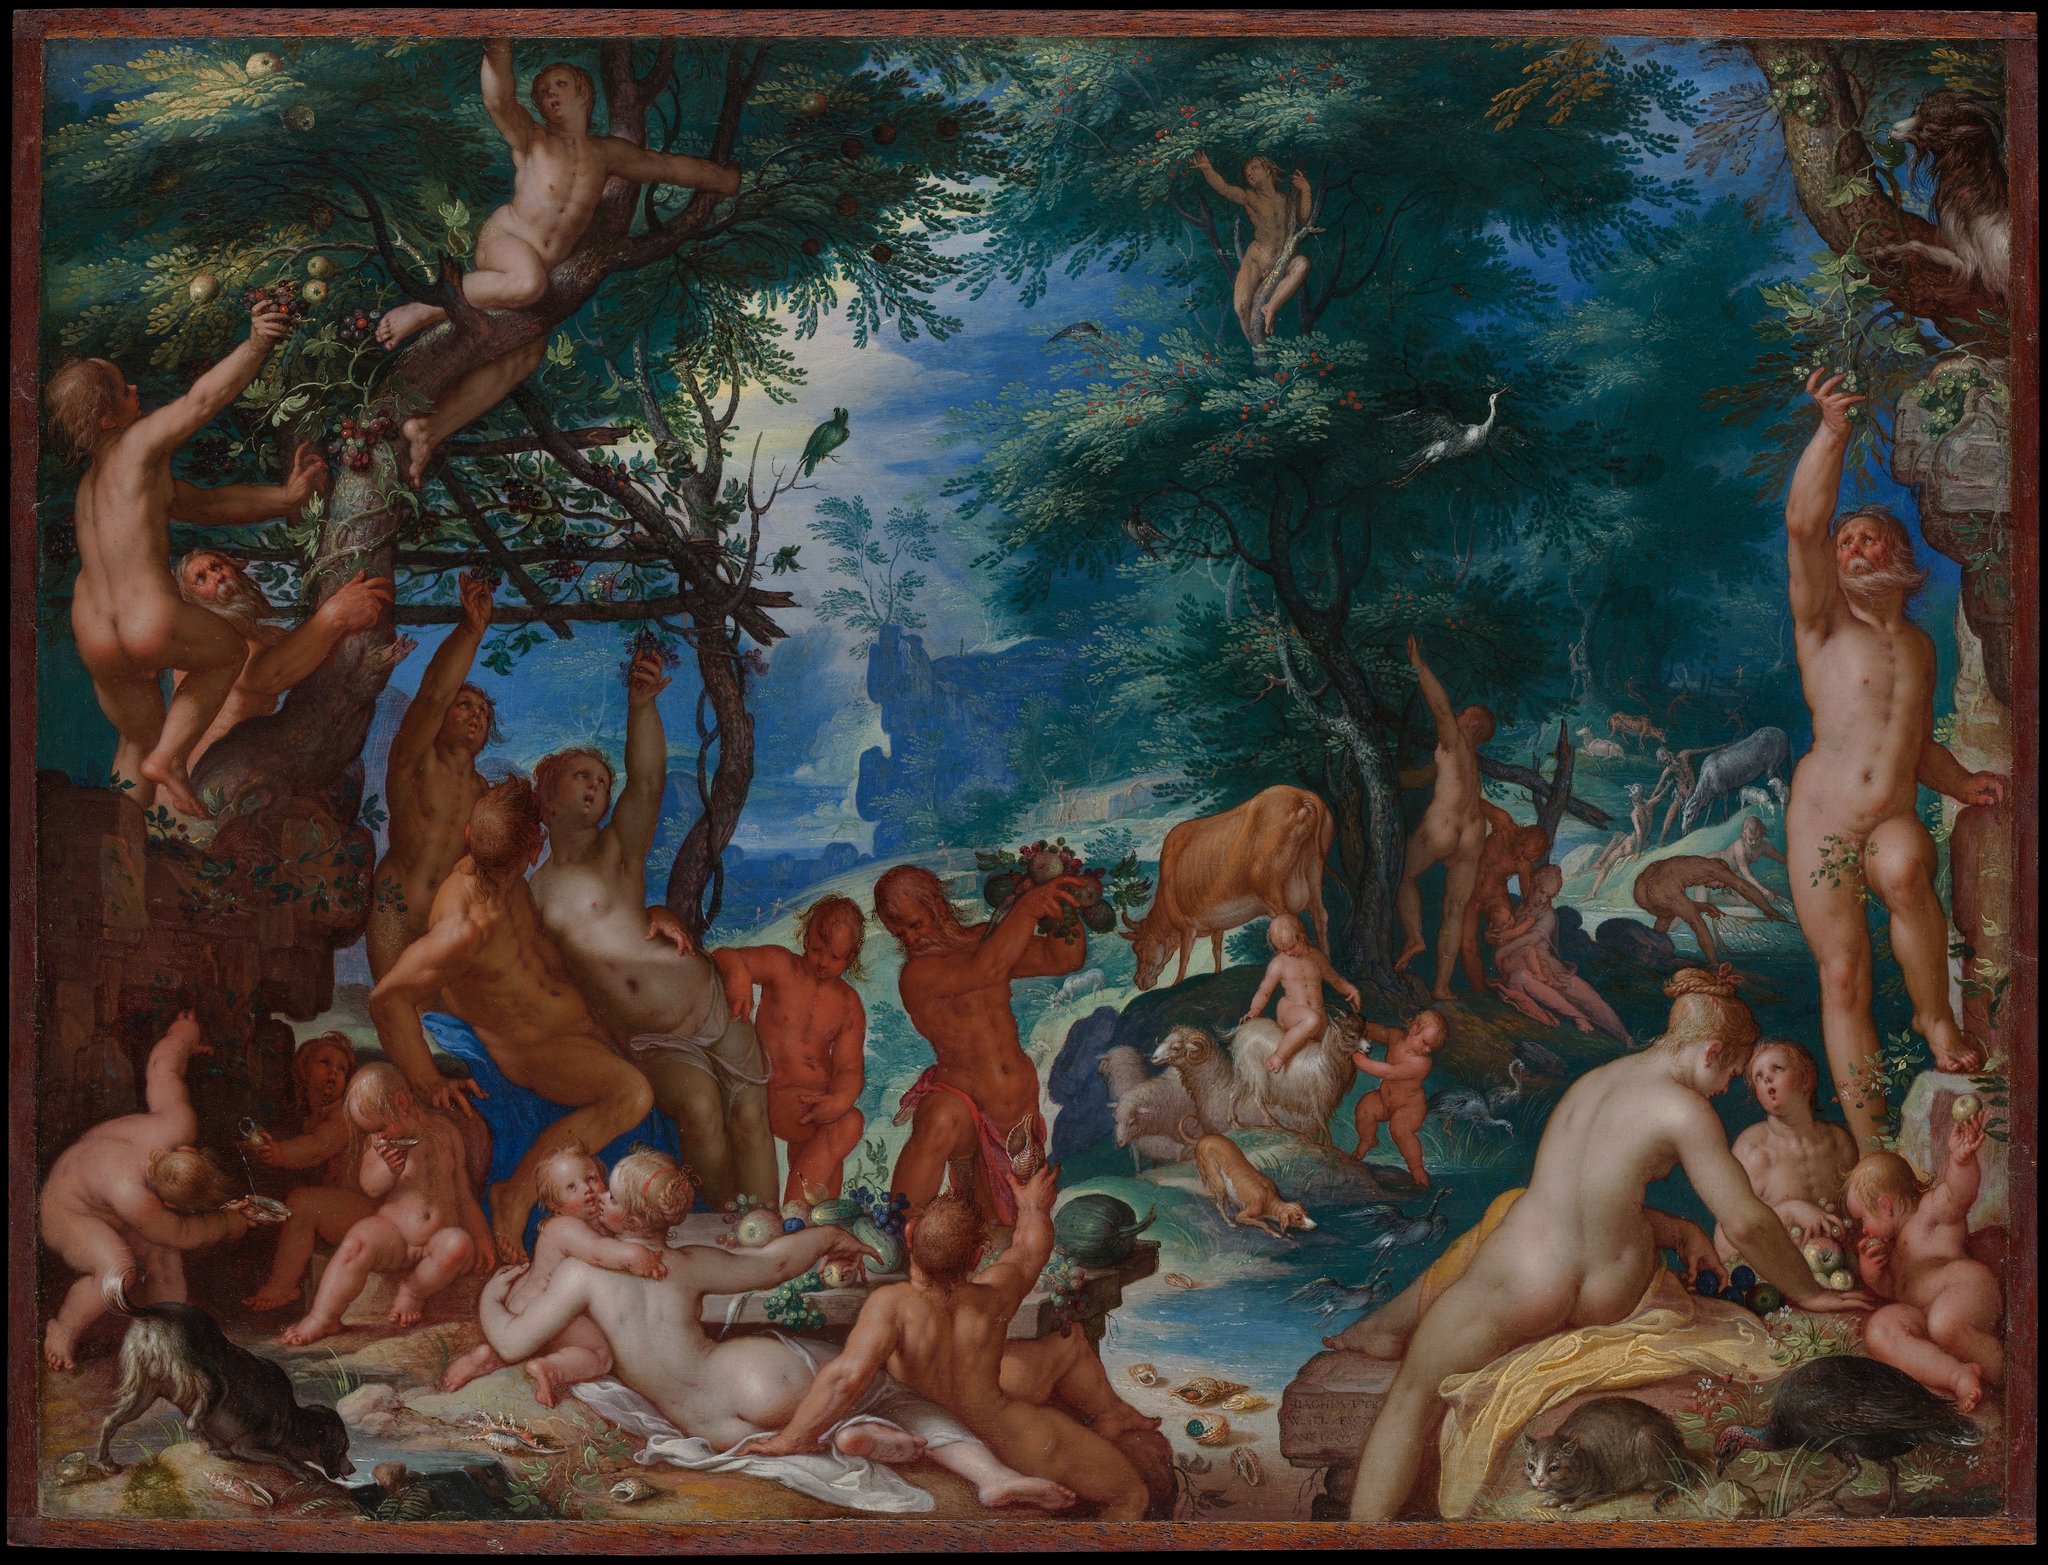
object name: painting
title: The Golden Age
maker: joachim wtewael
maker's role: artist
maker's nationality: netherlandish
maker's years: 1566-1638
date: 1605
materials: copper, oil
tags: birds,male nudes,female nudes,cats,cows,dogs,sheep